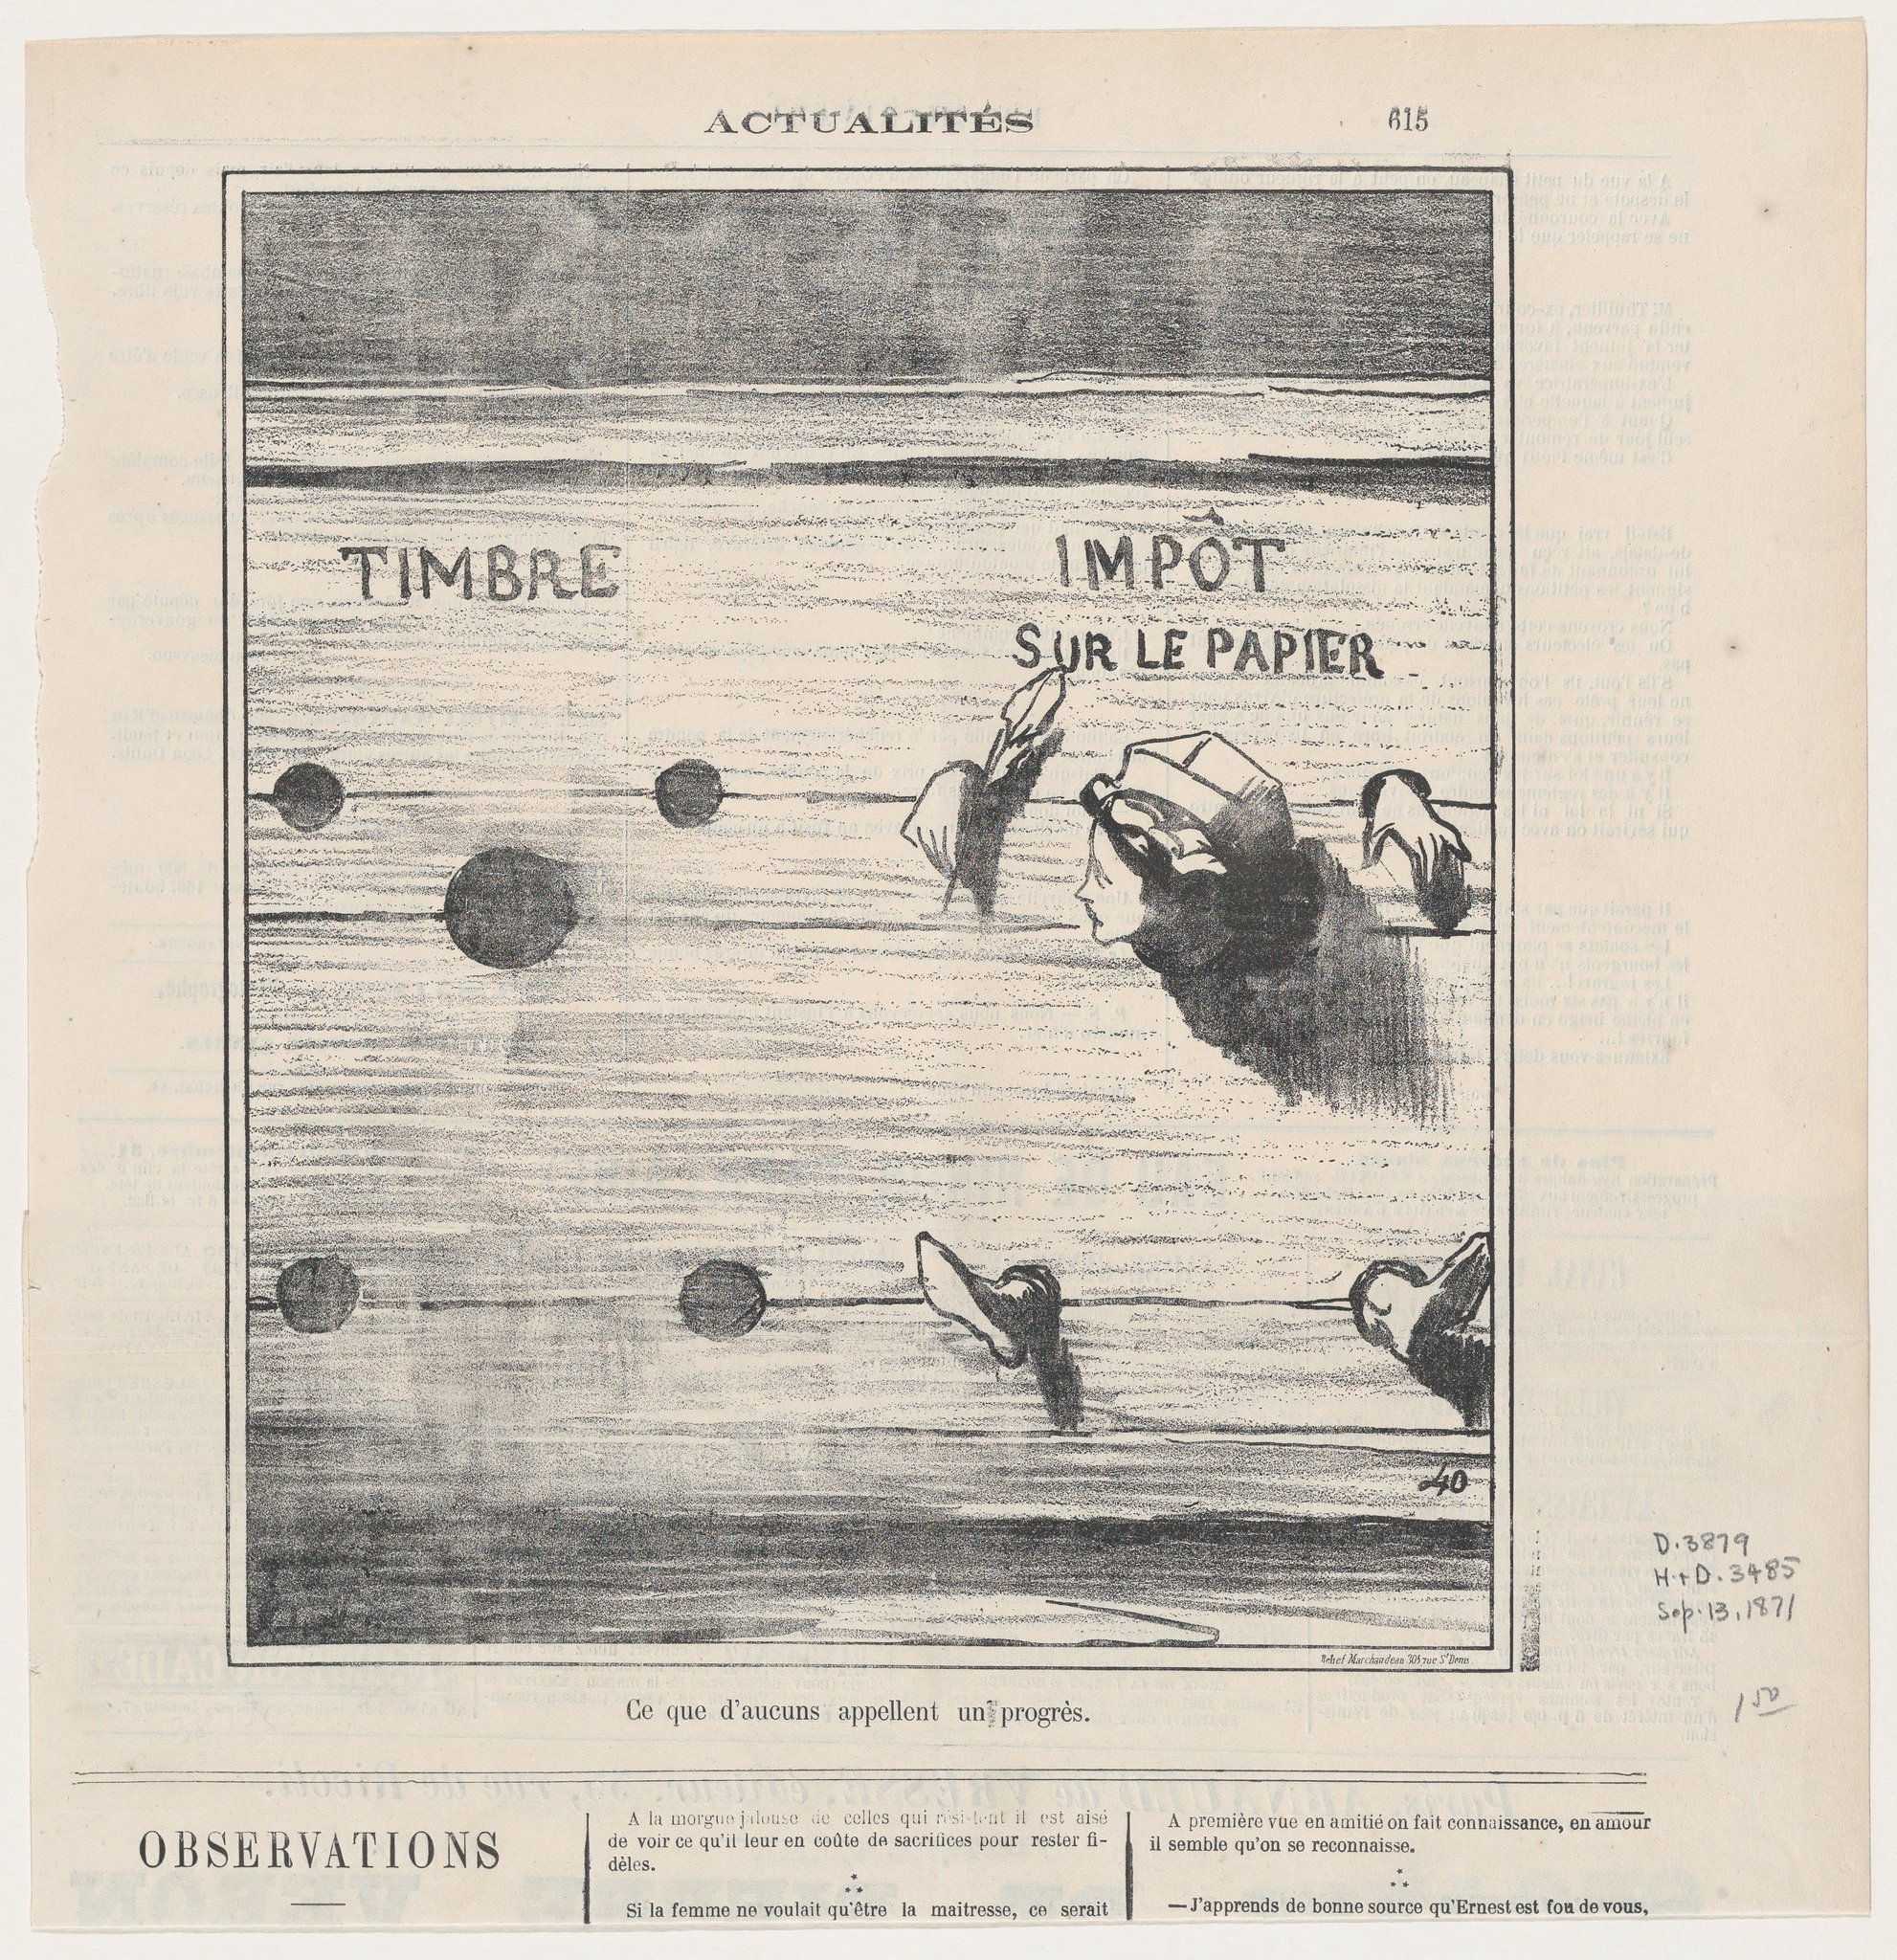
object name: print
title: What some call progress!, from 'News of the day,' published in Le Charivari, September 13, 1871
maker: honoré daumier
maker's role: artist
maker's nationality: french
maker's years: 1808-1879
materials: paper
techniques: lithograph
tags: satire,girls,profiles